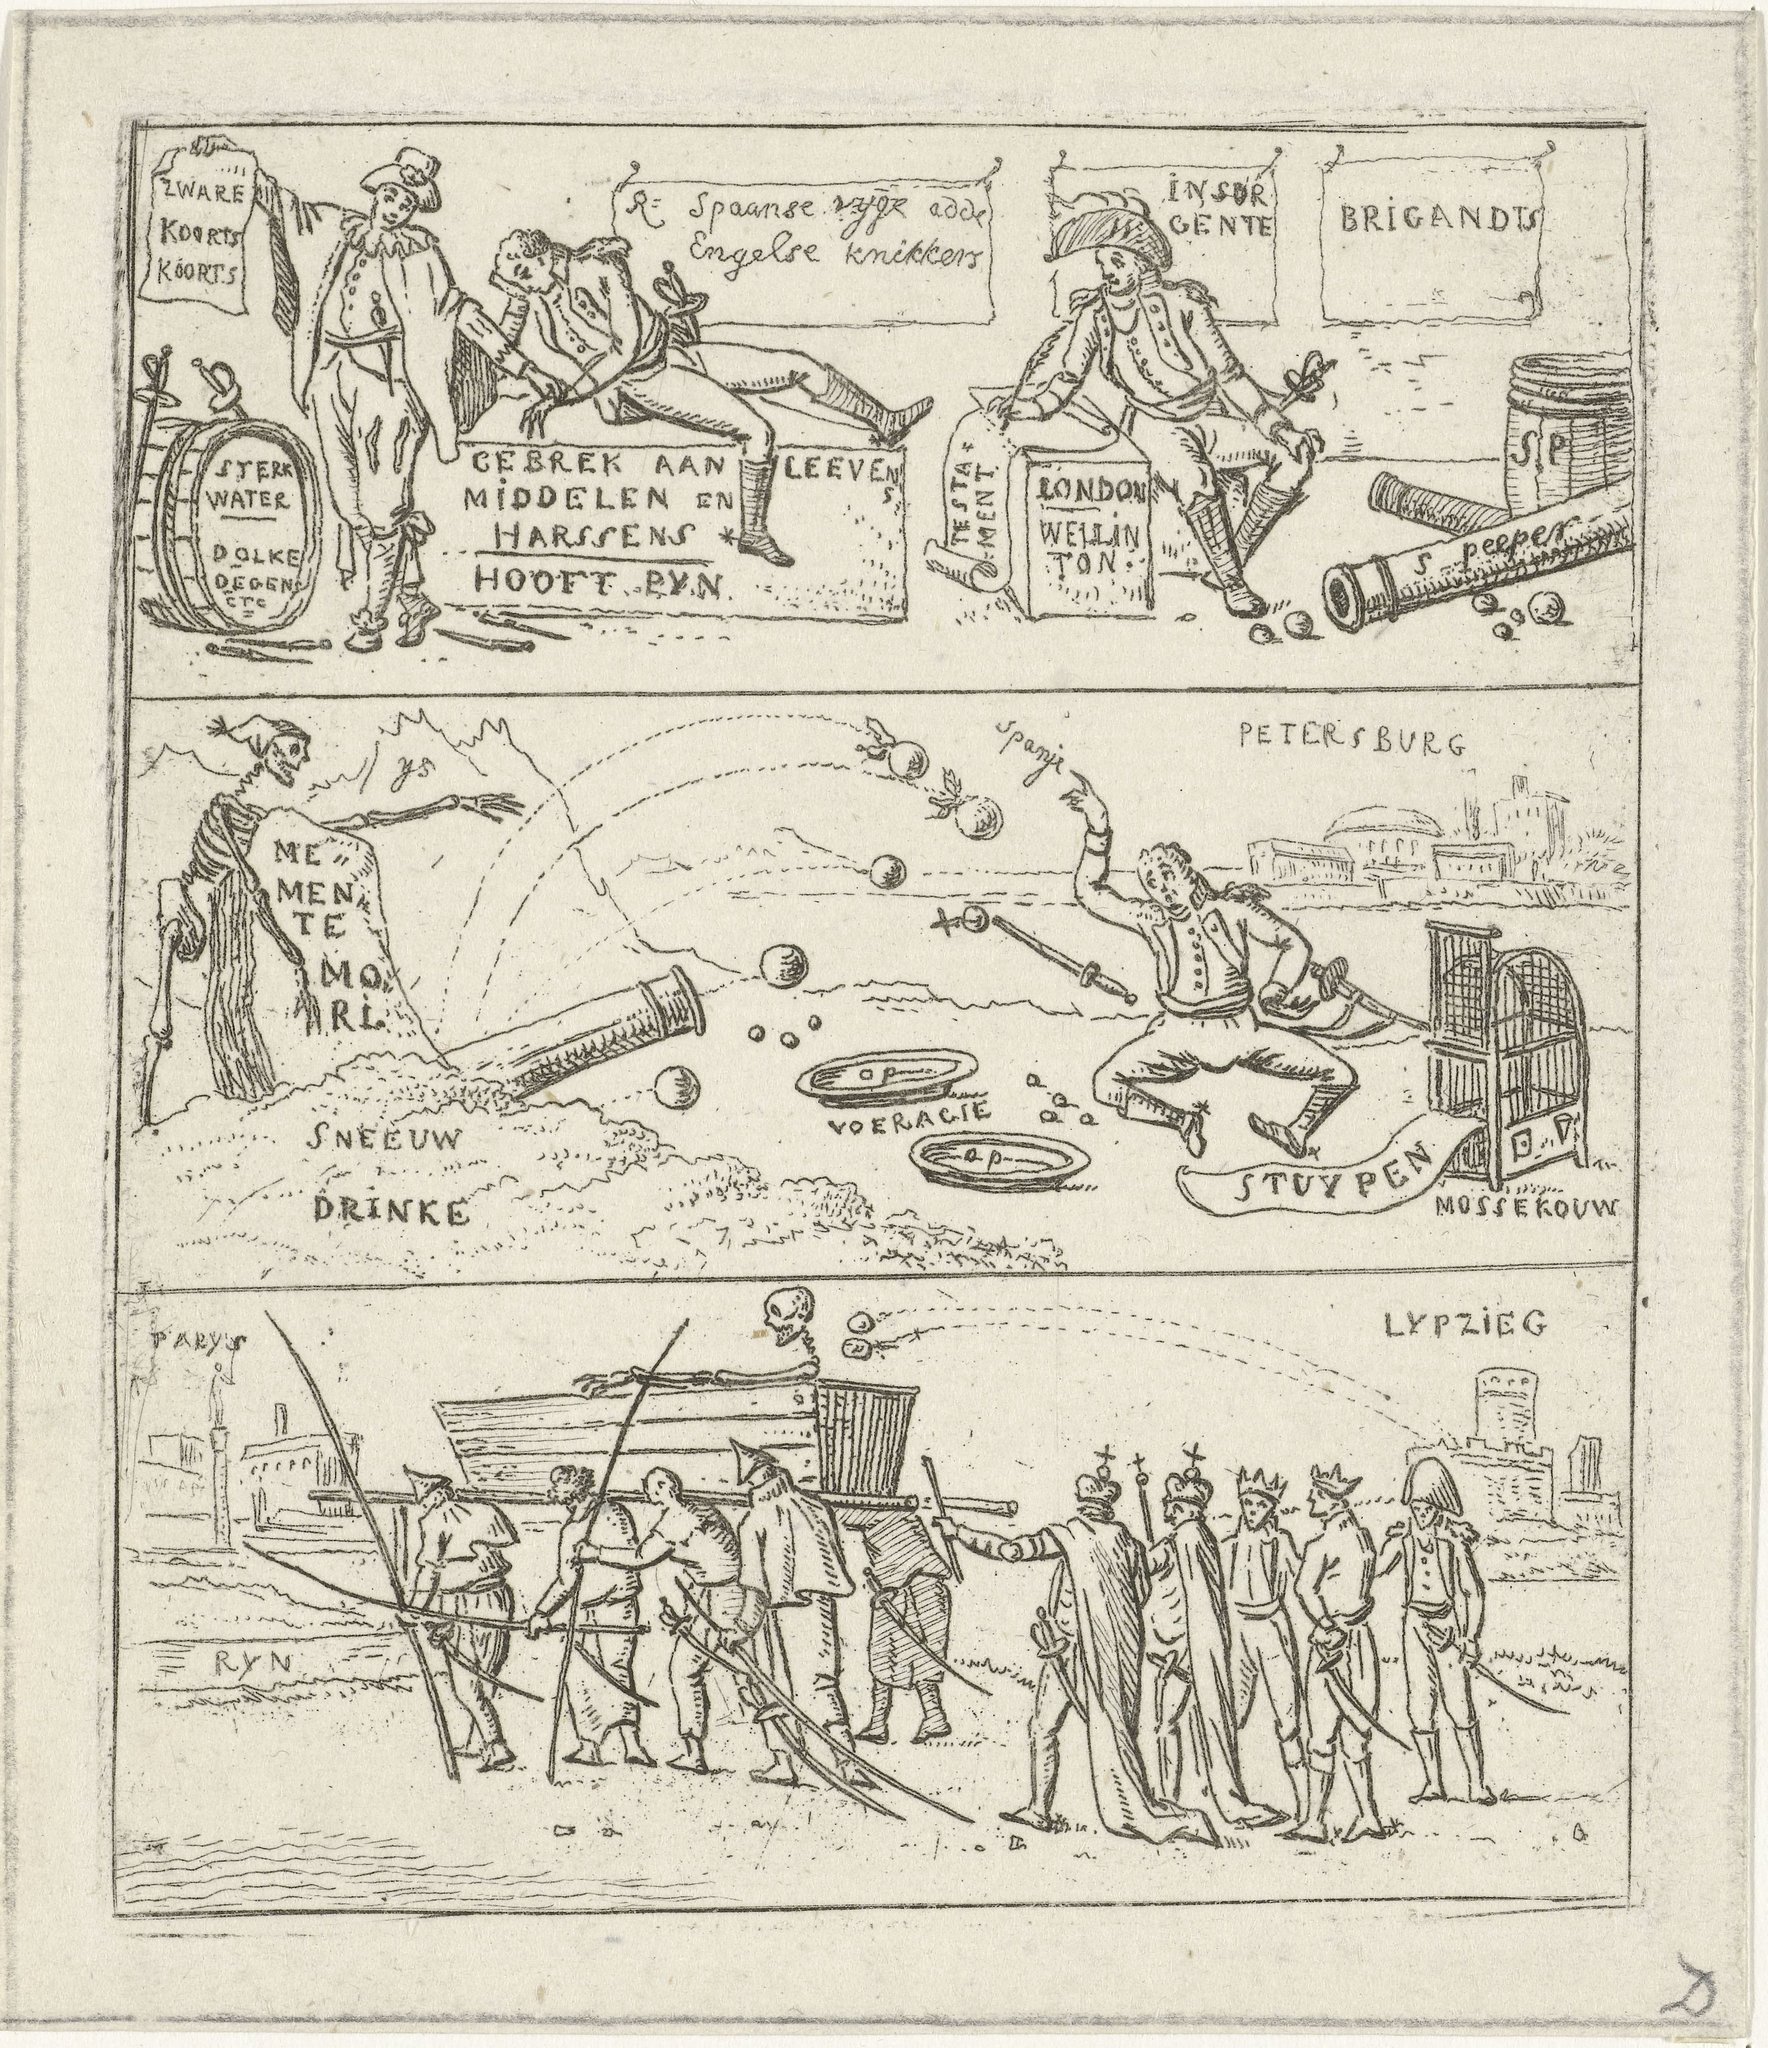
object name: cartoon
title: Spotprenten op de nederlagen der Fransen in 1813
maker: hermanus fock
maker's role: conservator, draughtsman, painter, print maker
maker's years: 1766-1822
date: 1813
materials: paper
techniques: etching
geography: amsterdam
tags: carrying the sick, wounded and dead off the battle-field, the soldier; the soldier's life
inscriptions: collector's mark: Lugt 2228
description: Boven een Franse soldaat die zijn testament maakt na de nederlaag van de Fransen in Spanje. In het midden een soldaat die door kogels getroffen wordt. Op de achtergrond de stad St. Petersburg. Onder wordt een doodskist met een geraamte terug naar Parijs gedragen. Uit de stad Leipzig komt een kanonskogel gevlogen.